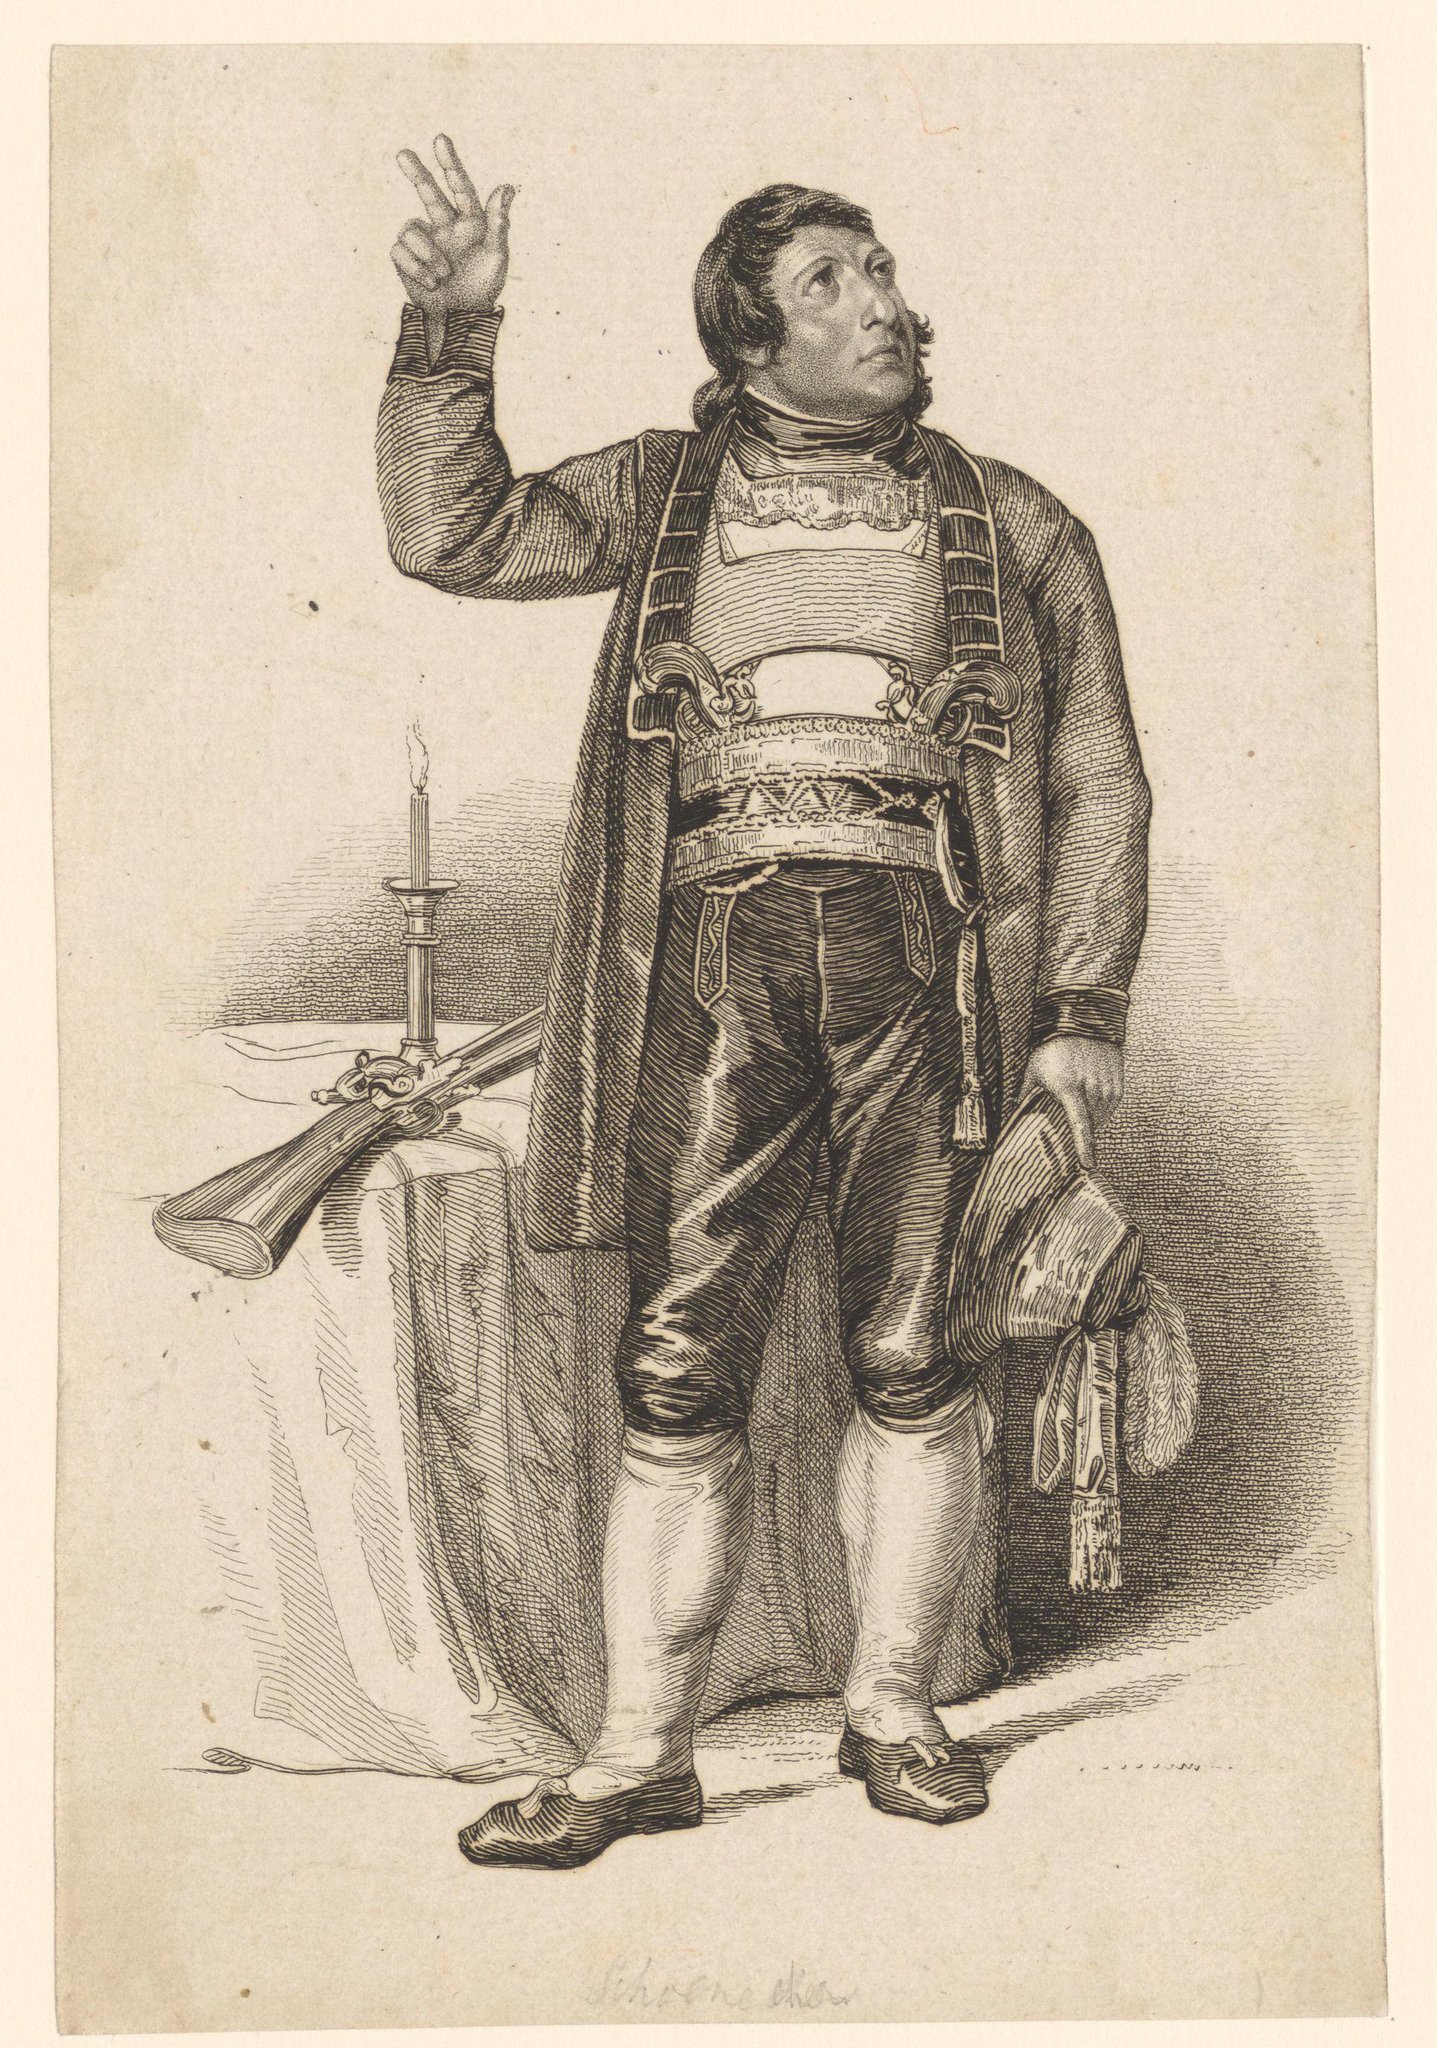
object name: print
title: Portret van commandant Schoenecher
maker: Anonymous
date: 1809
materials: paper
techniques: etching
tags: commander-in-chief, general, marshal, historical persons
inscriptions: collector's mark: Lugt 2228